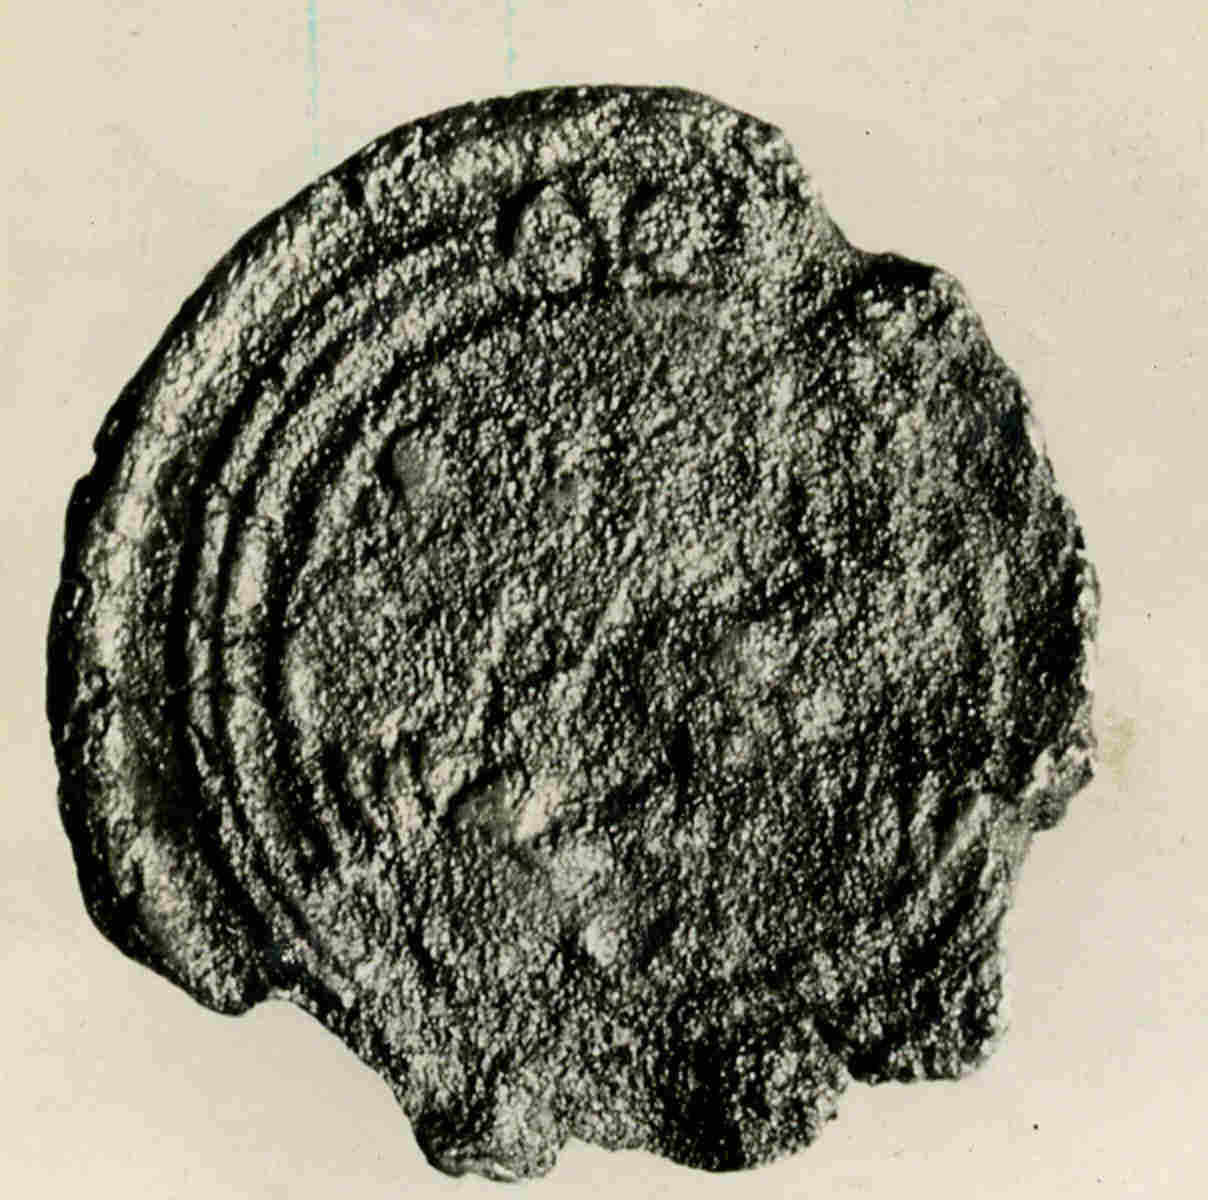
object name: coin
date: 758-768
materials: copper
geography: iran